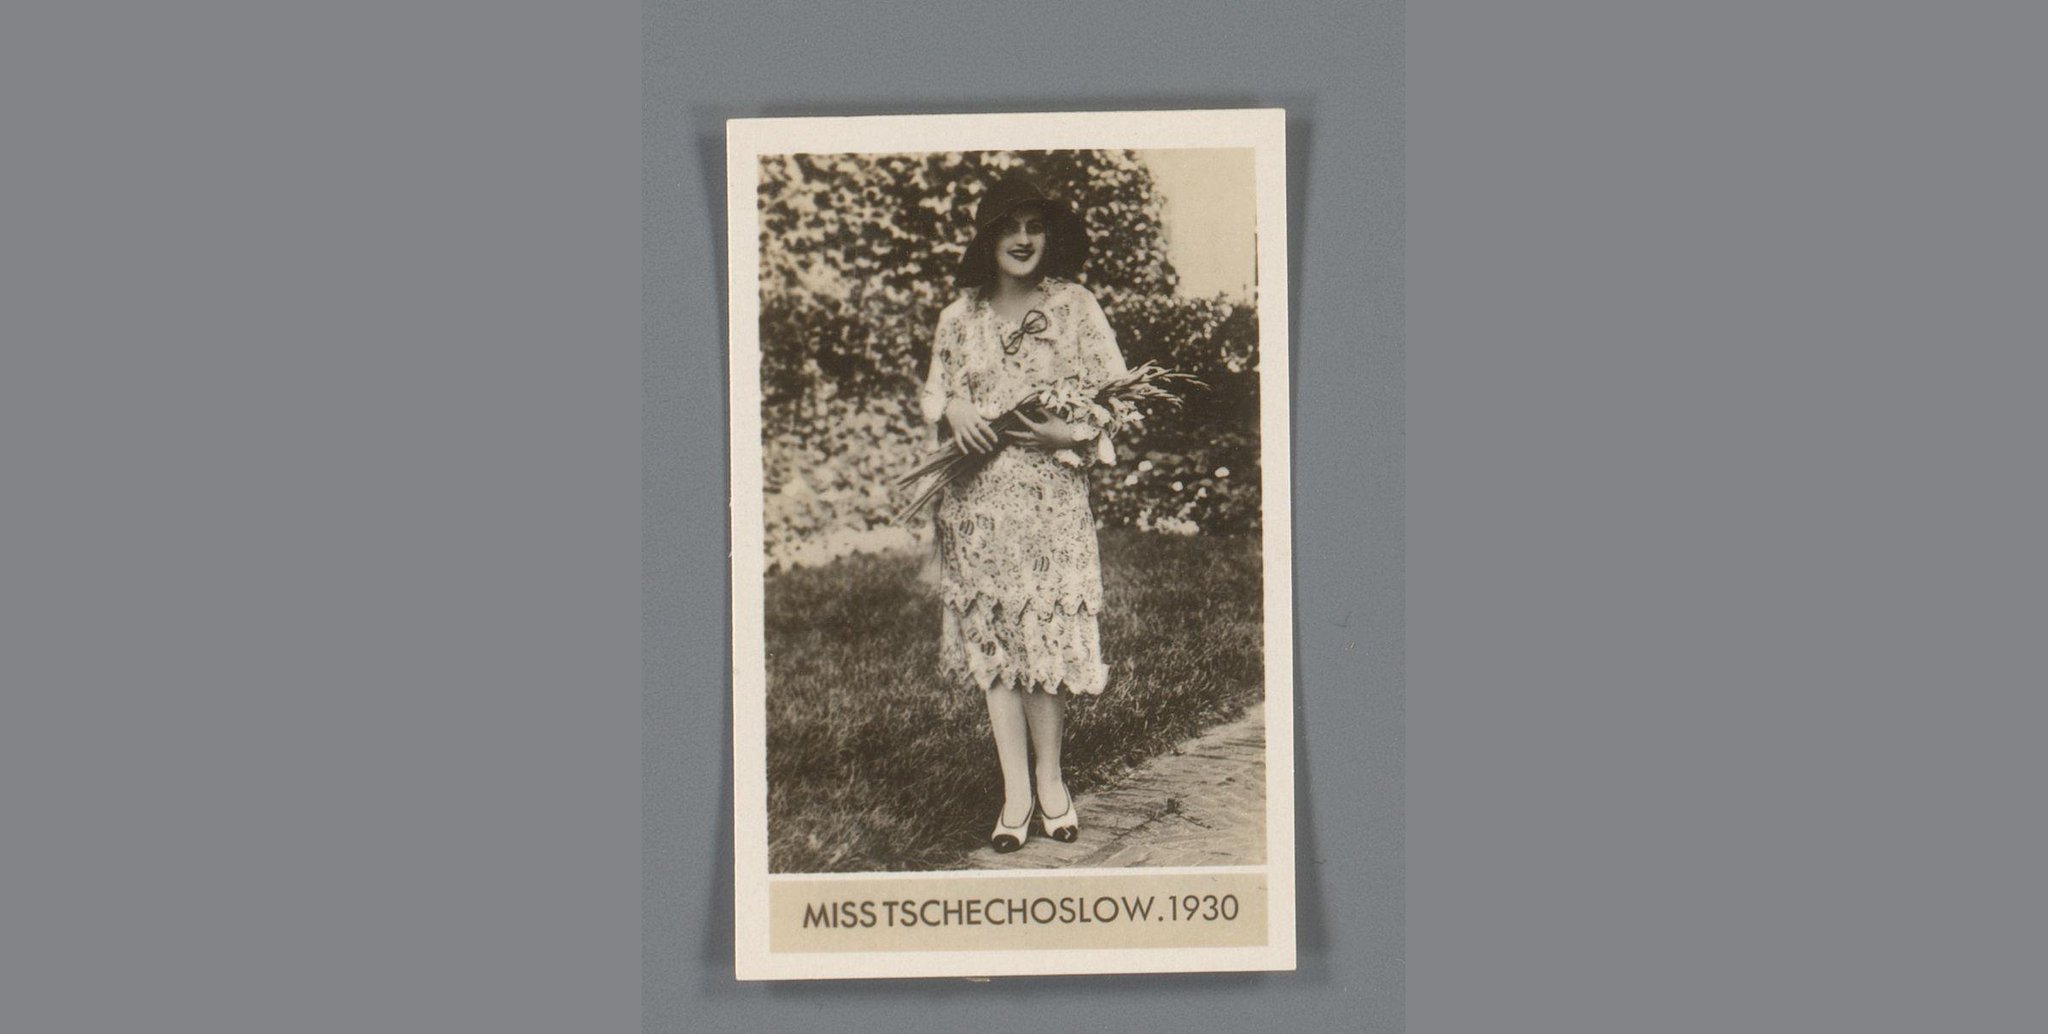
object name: photograph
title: Portret van Milada Dostálová, Miss Tsjecho-Slowakije 1930, reclame voor Club & Liga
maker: Anonymous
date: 1930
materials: paper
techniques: gelatin silver print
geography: dresden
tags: historical persons - bb - woman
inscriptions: inscription: ‘Die schönsten/ Frauen der Welt/ dargestellt durch die Schön-/ heitsköniginnen aller Länder,/ finden Sie in 190 echten/ Bromsilber-Fotos, die nur den/ CLUB-und-LIGA-Packun-/ gen beiliegen. Eind prächtiges/ Sammel-Album erhalten Sie/ für 75 Pfennig vom Händler/ oder bei Einsendung von/ 75 Pfennig in Briefmarken/ von der Bilderstelle Lohse,/ Dresden A24, Nossener Str. 1./ Ges. gesch. Nachdruck verboten!’